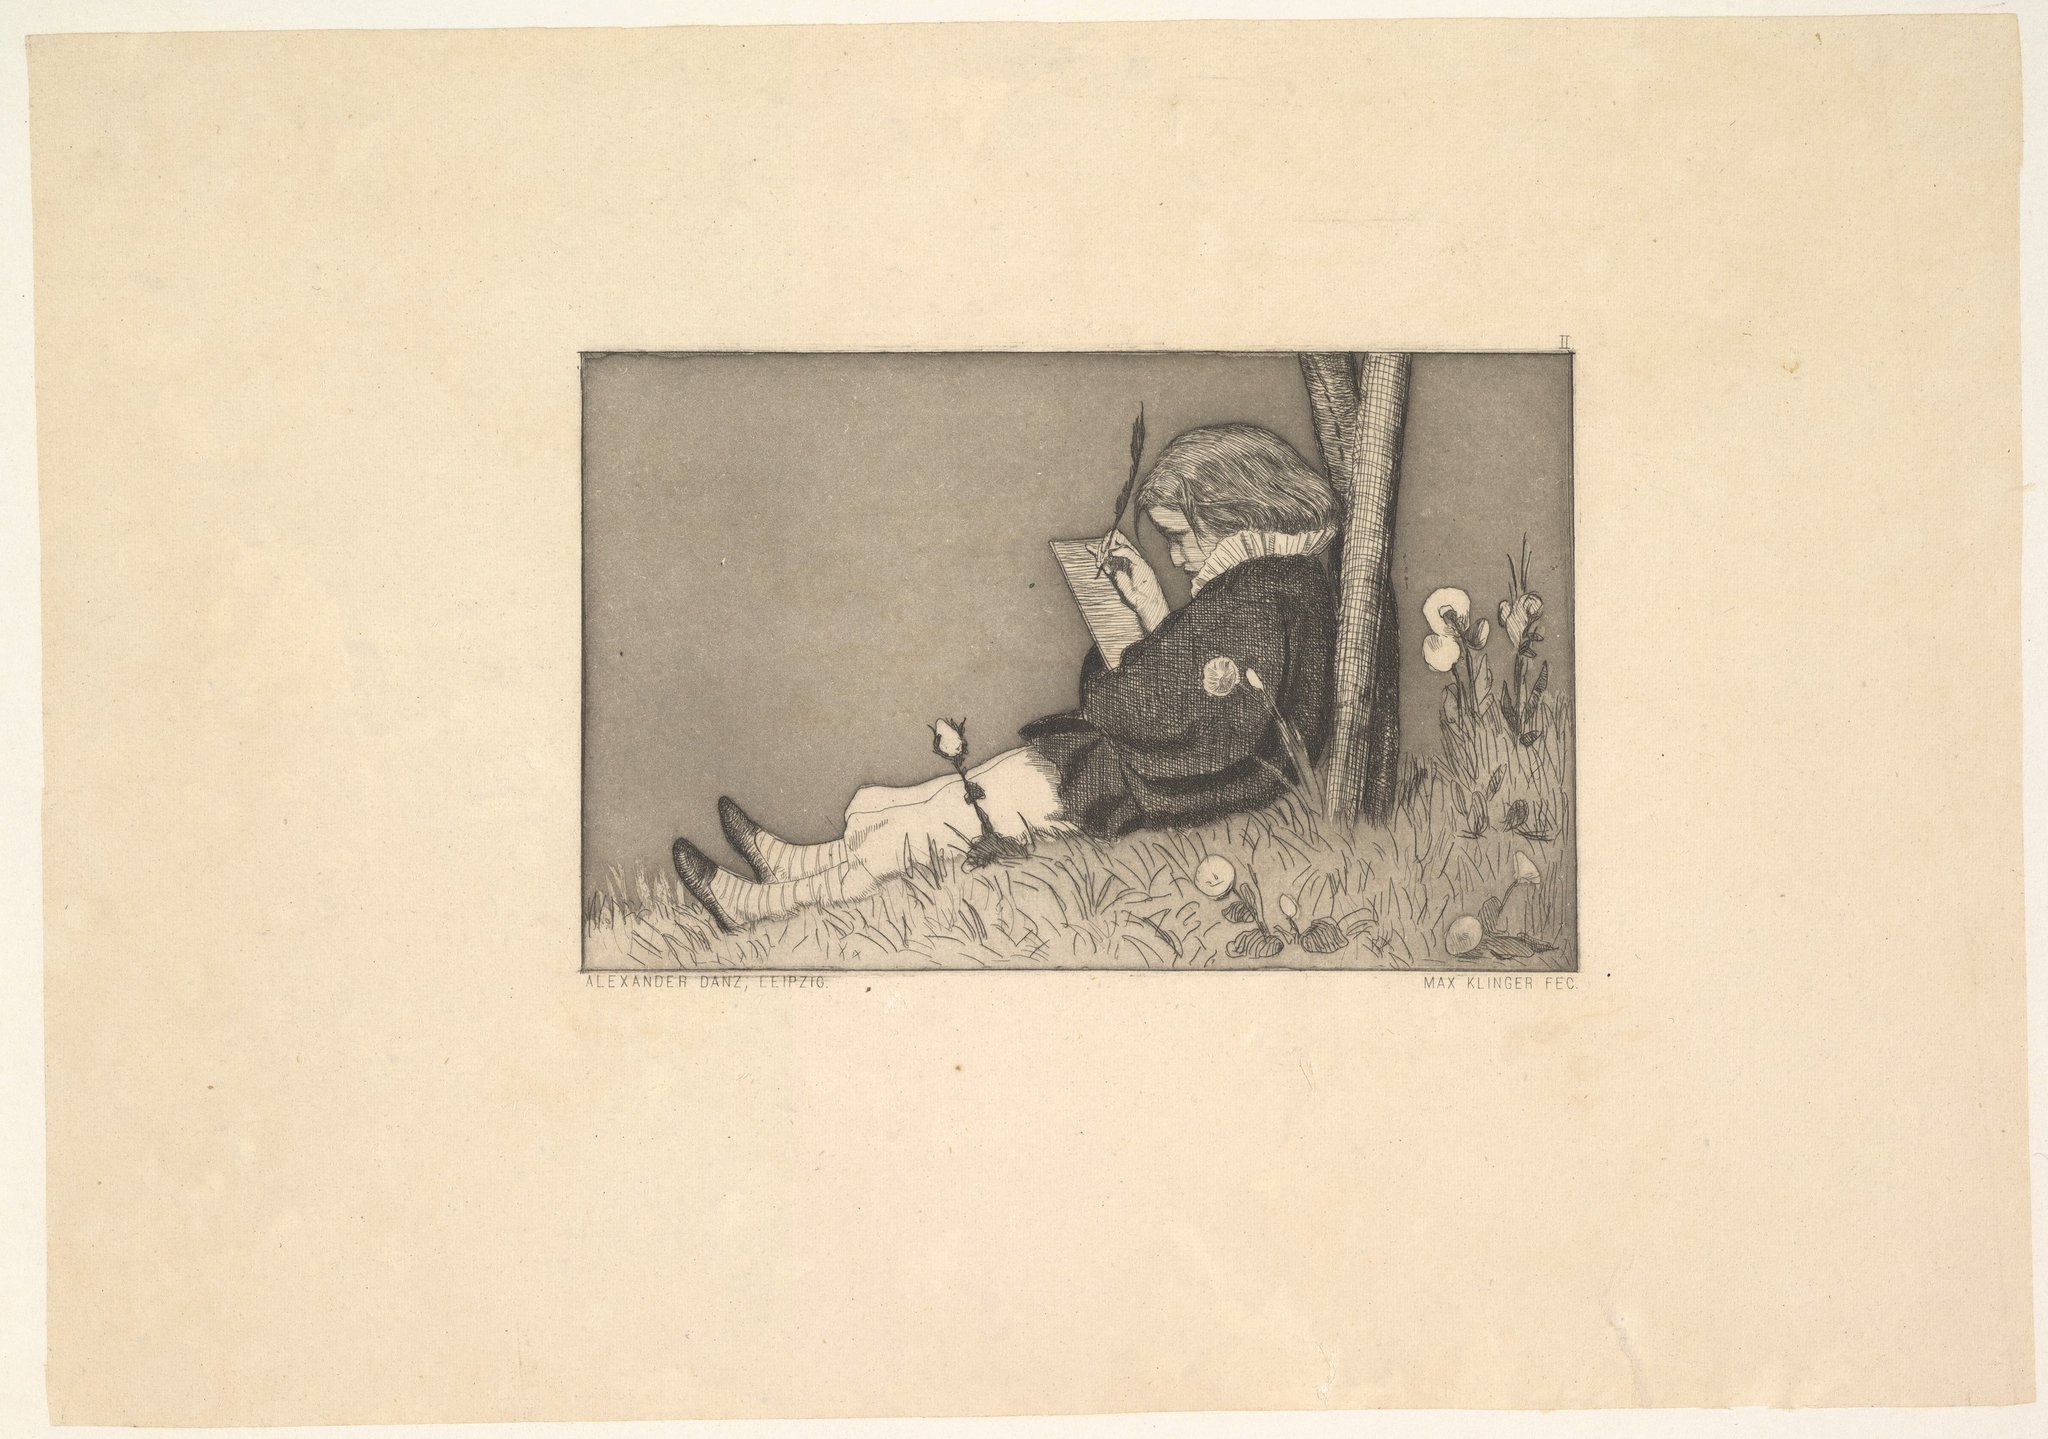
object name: print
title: Malerische Zueignung, from the series Radierte Skizzen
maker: max klinger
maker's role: artist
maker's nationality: german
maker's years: 1857-1920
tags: boys,writing